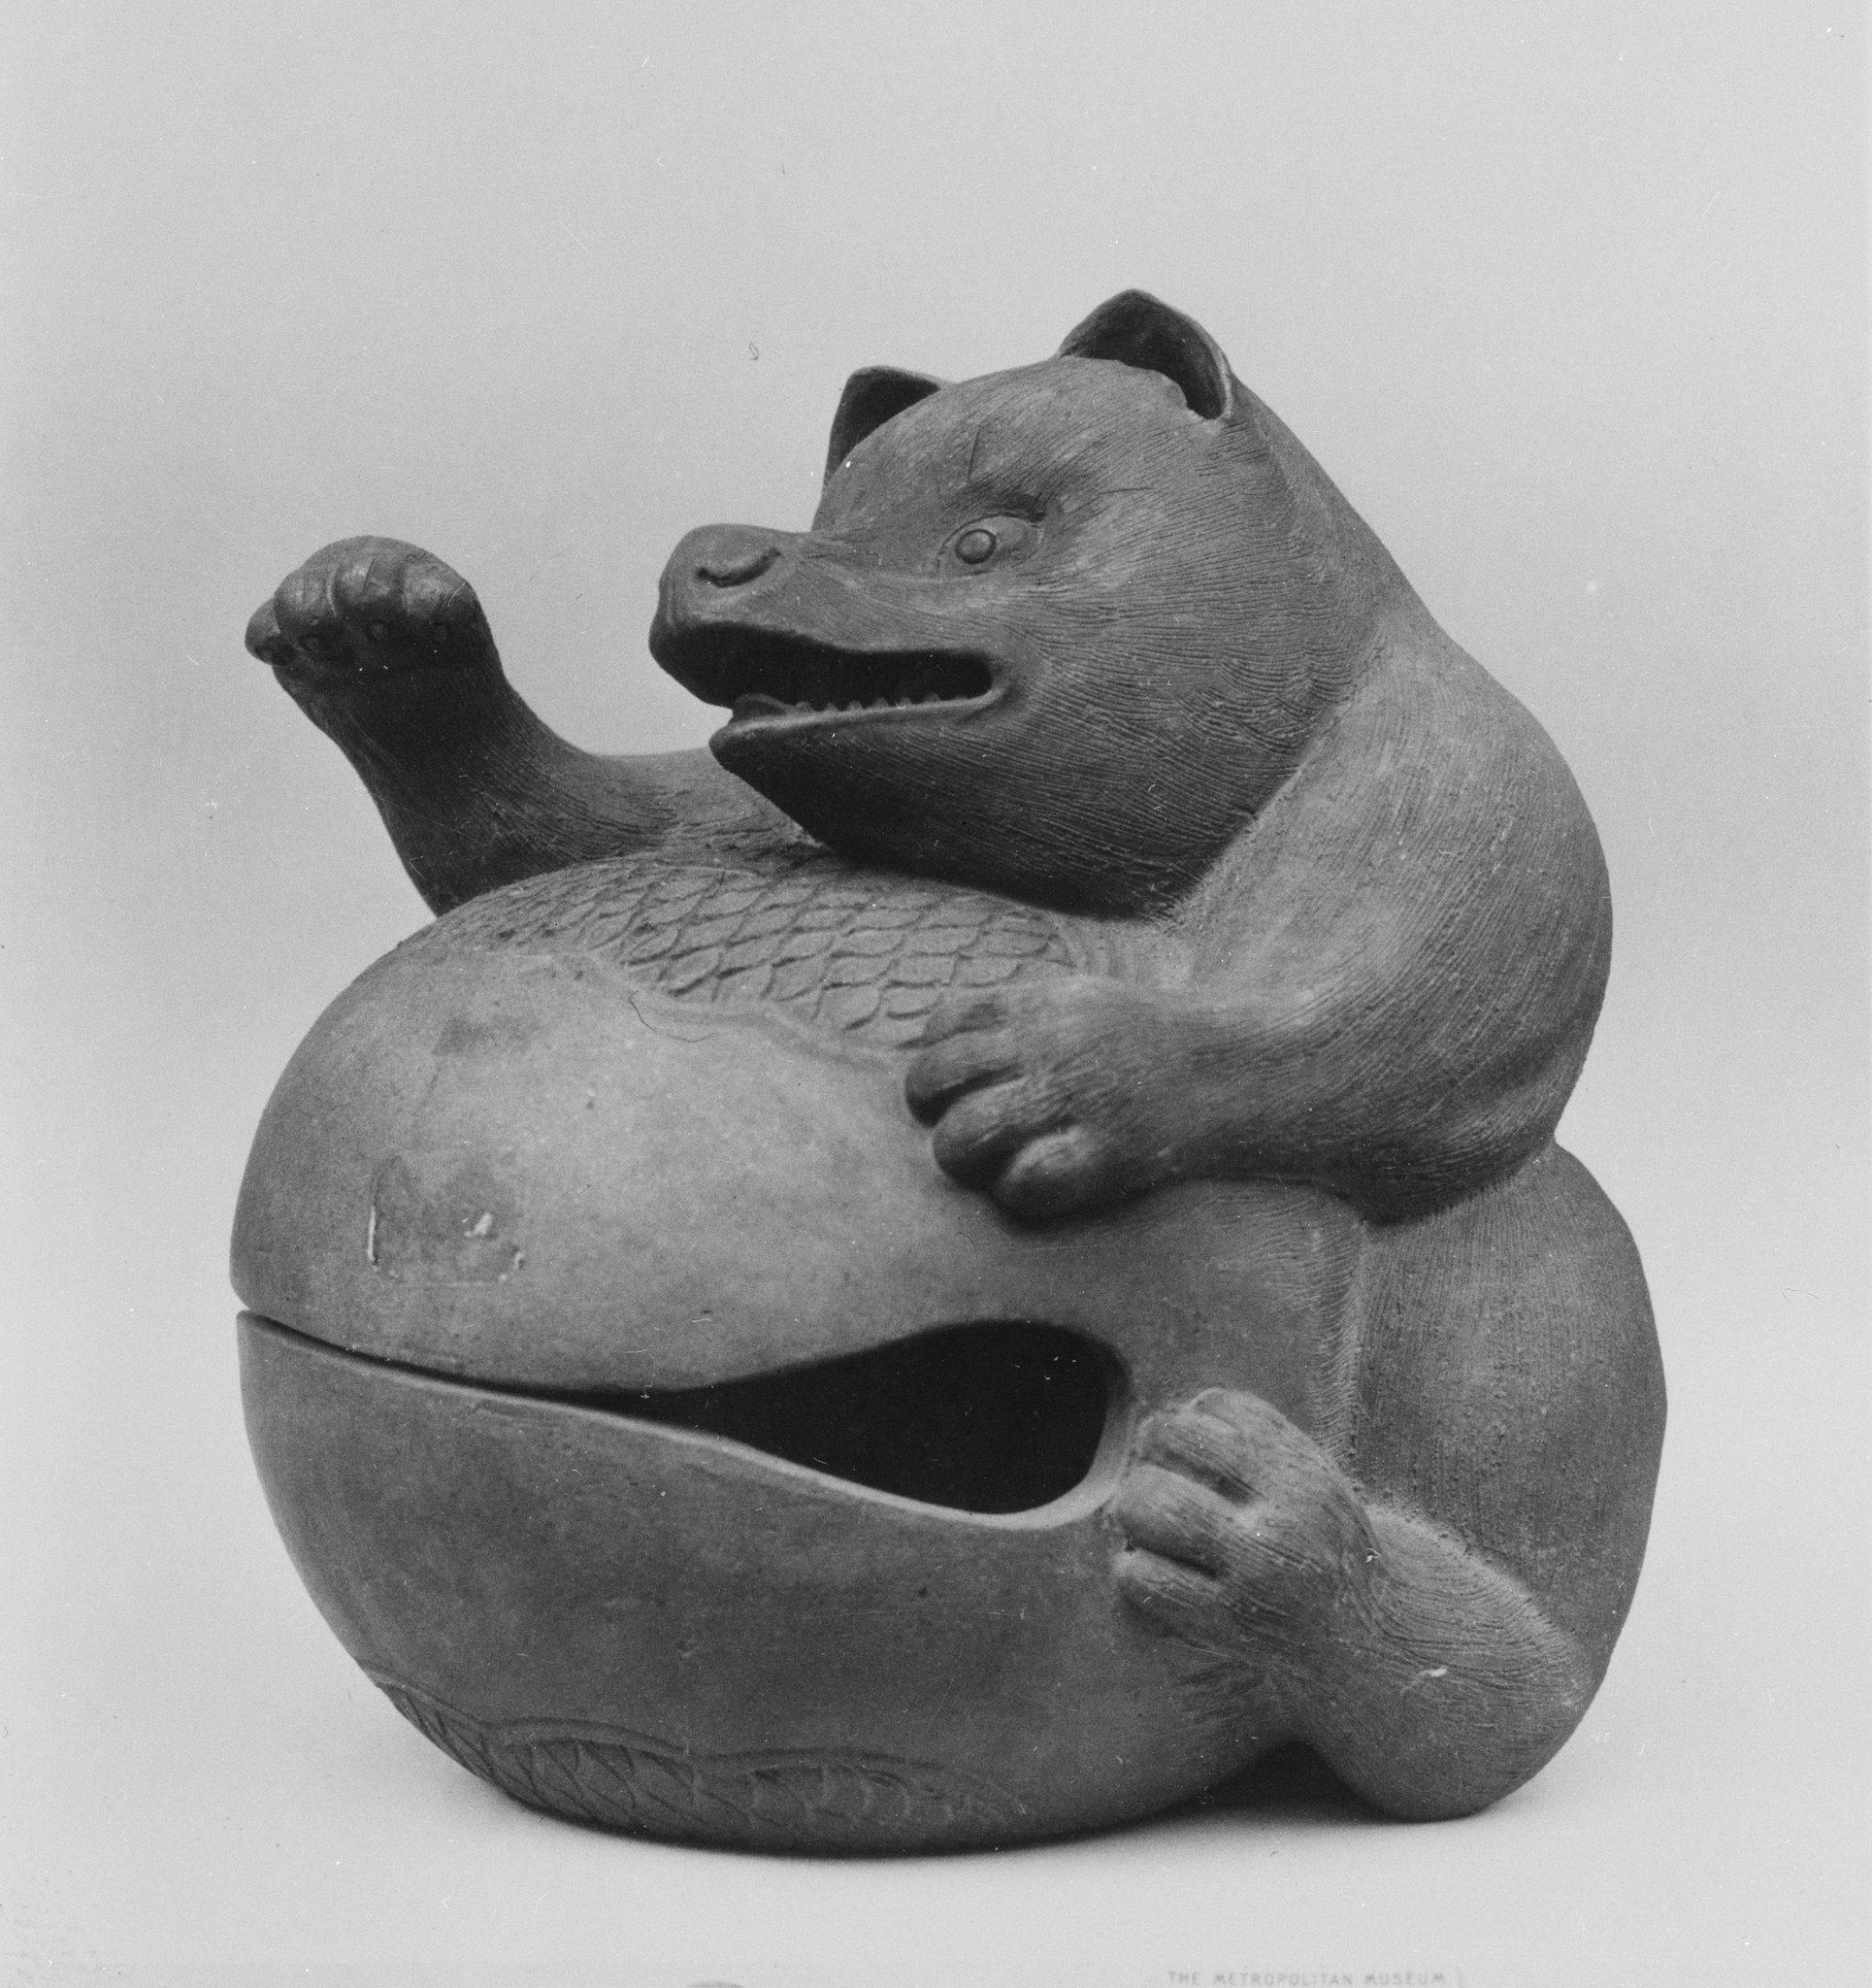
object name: fire box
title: Fire Box in form of a Badger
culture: japanese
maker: aoki mokubei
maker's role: artist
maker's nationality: japanese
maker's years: 1767-1833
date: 1800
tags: animals